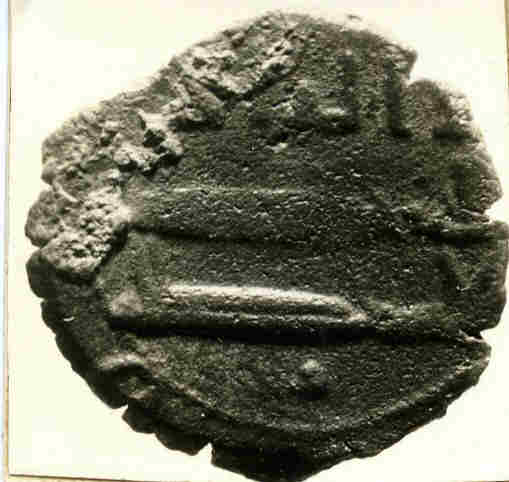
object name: coin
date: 815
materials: copper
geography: iran